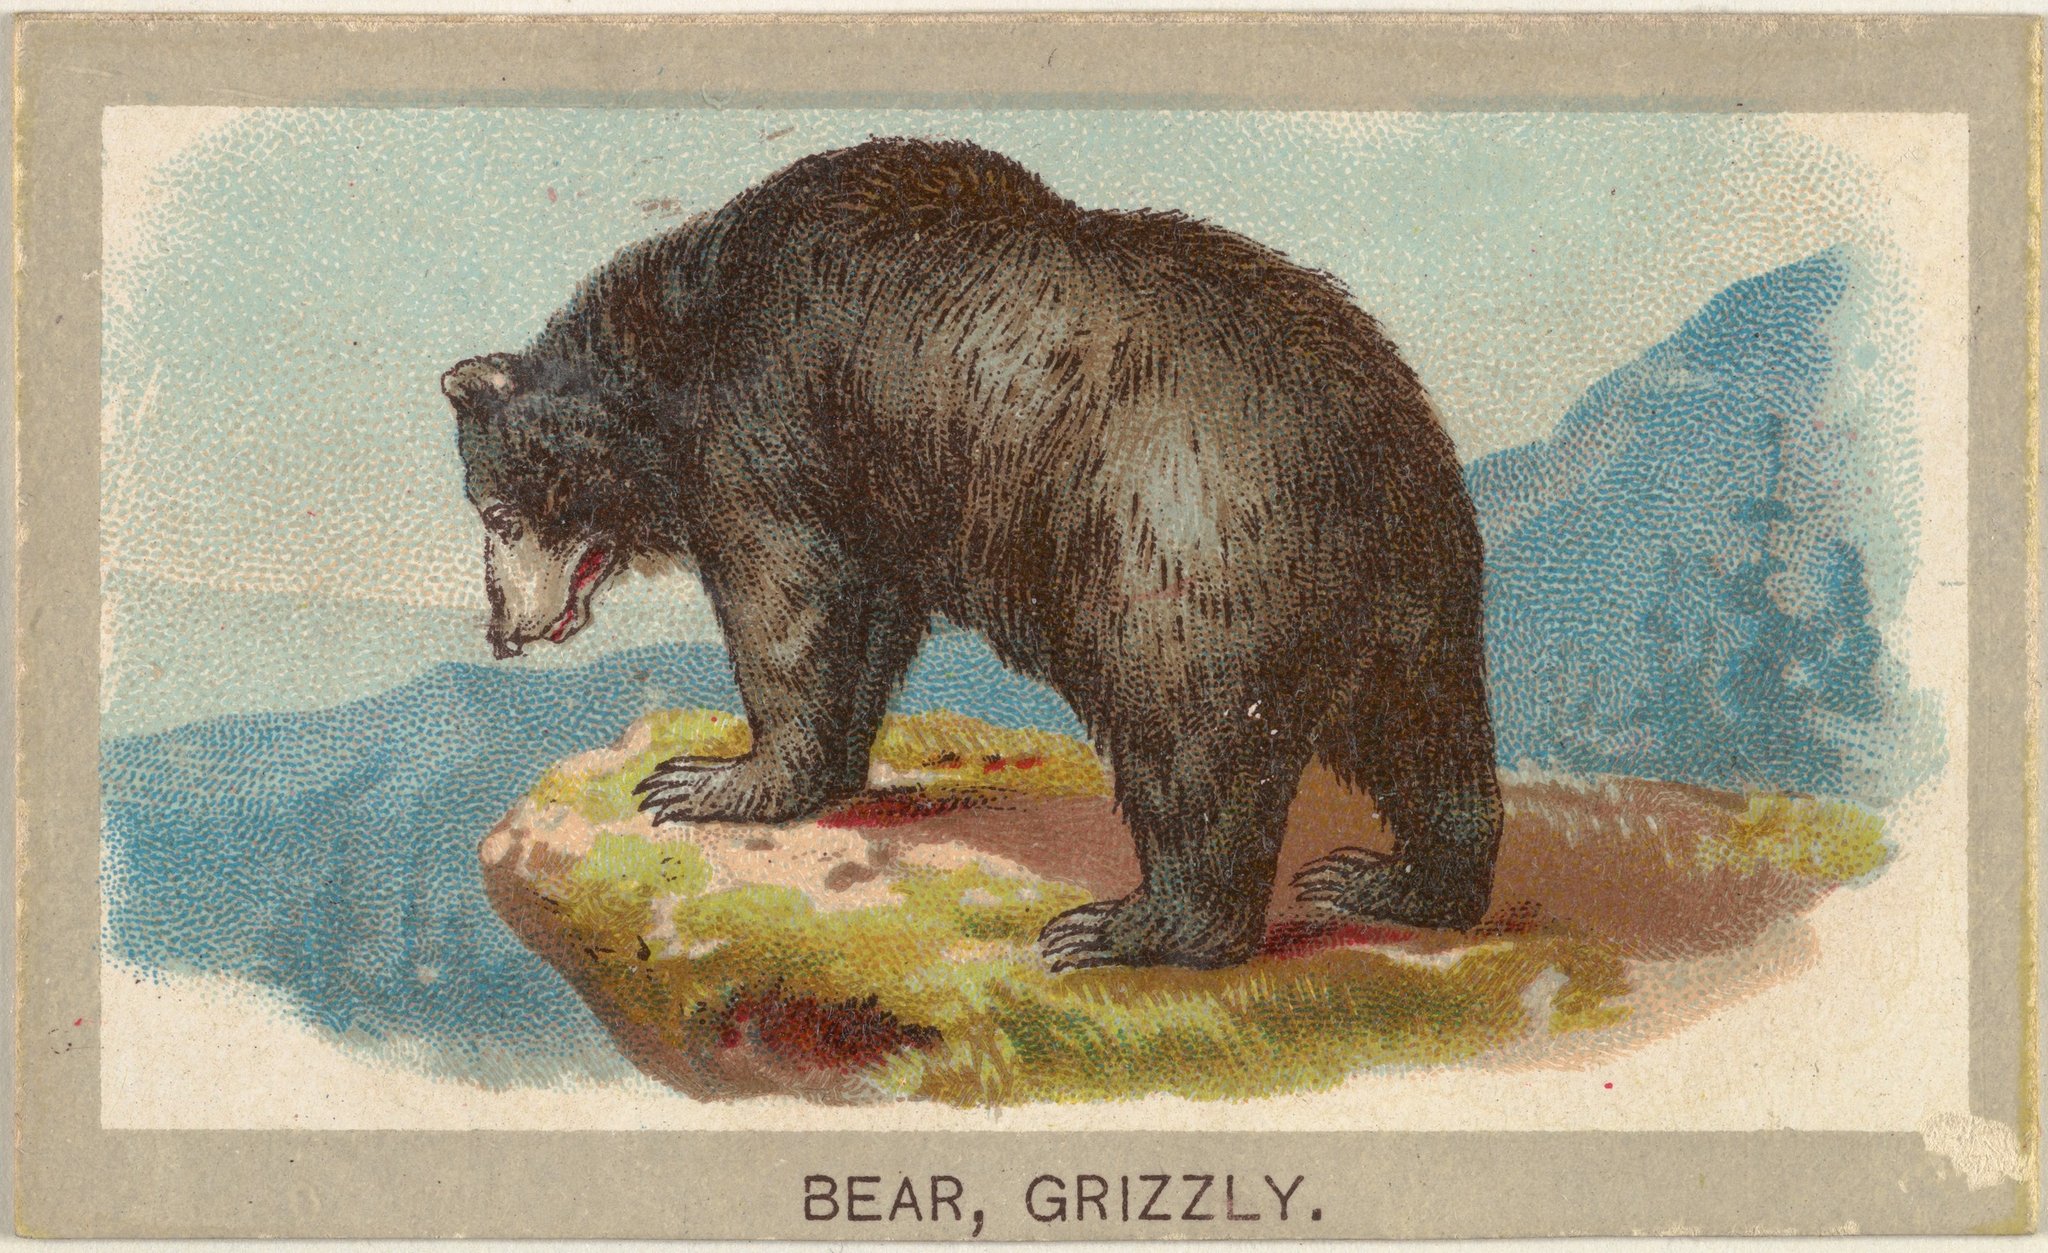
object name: print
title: Grizzly Bear, from the Animals of the World series (T180), issued by Abdul Cigarettes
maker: abdul cigarettes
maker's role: publisher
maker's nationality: american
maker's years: 1881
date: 1881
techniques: color lithograph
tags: bears